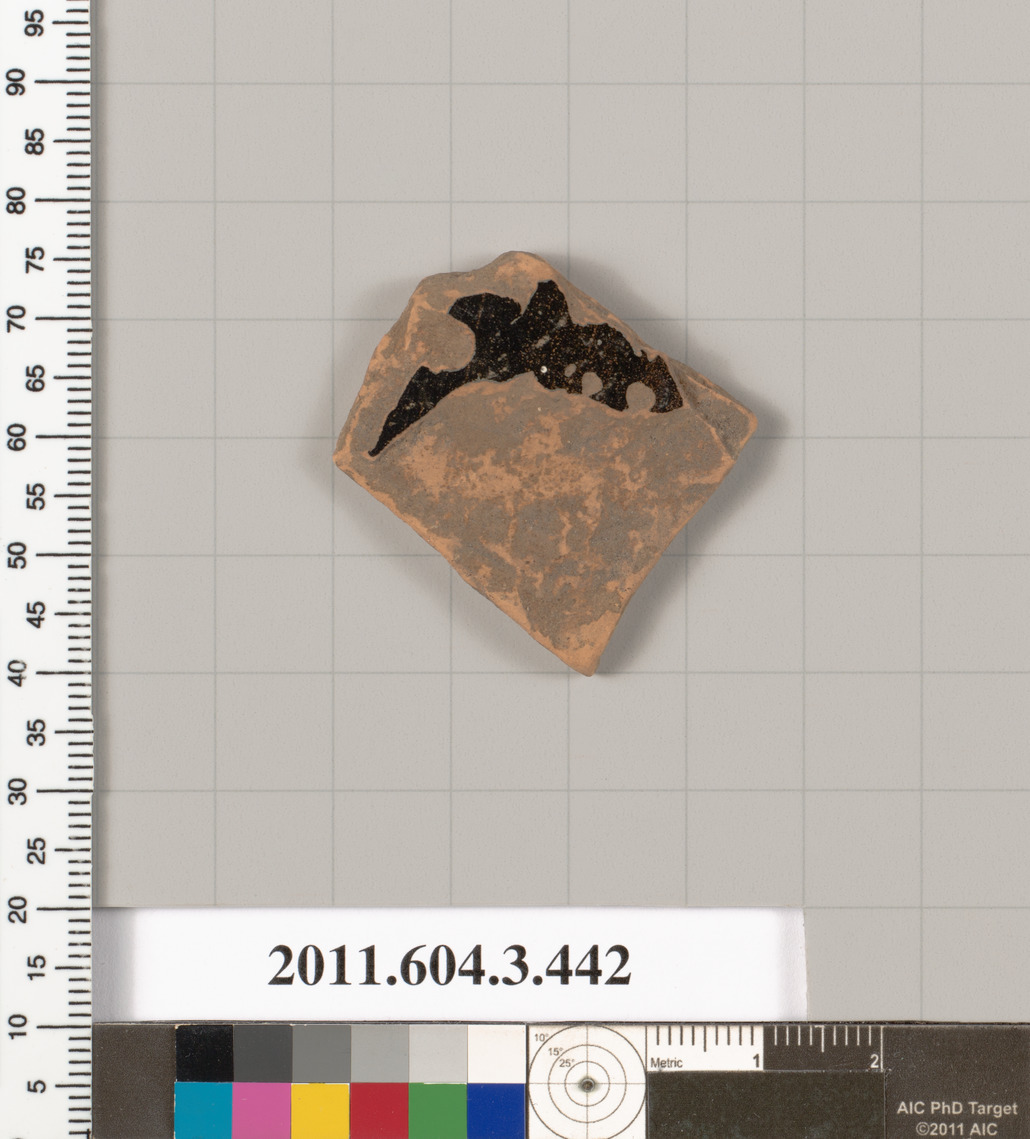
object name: neck amphora fragment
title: Terracotta fragment of a neck-amphora (jar)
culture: greek, attic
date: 600-401 BCE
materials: terracotta